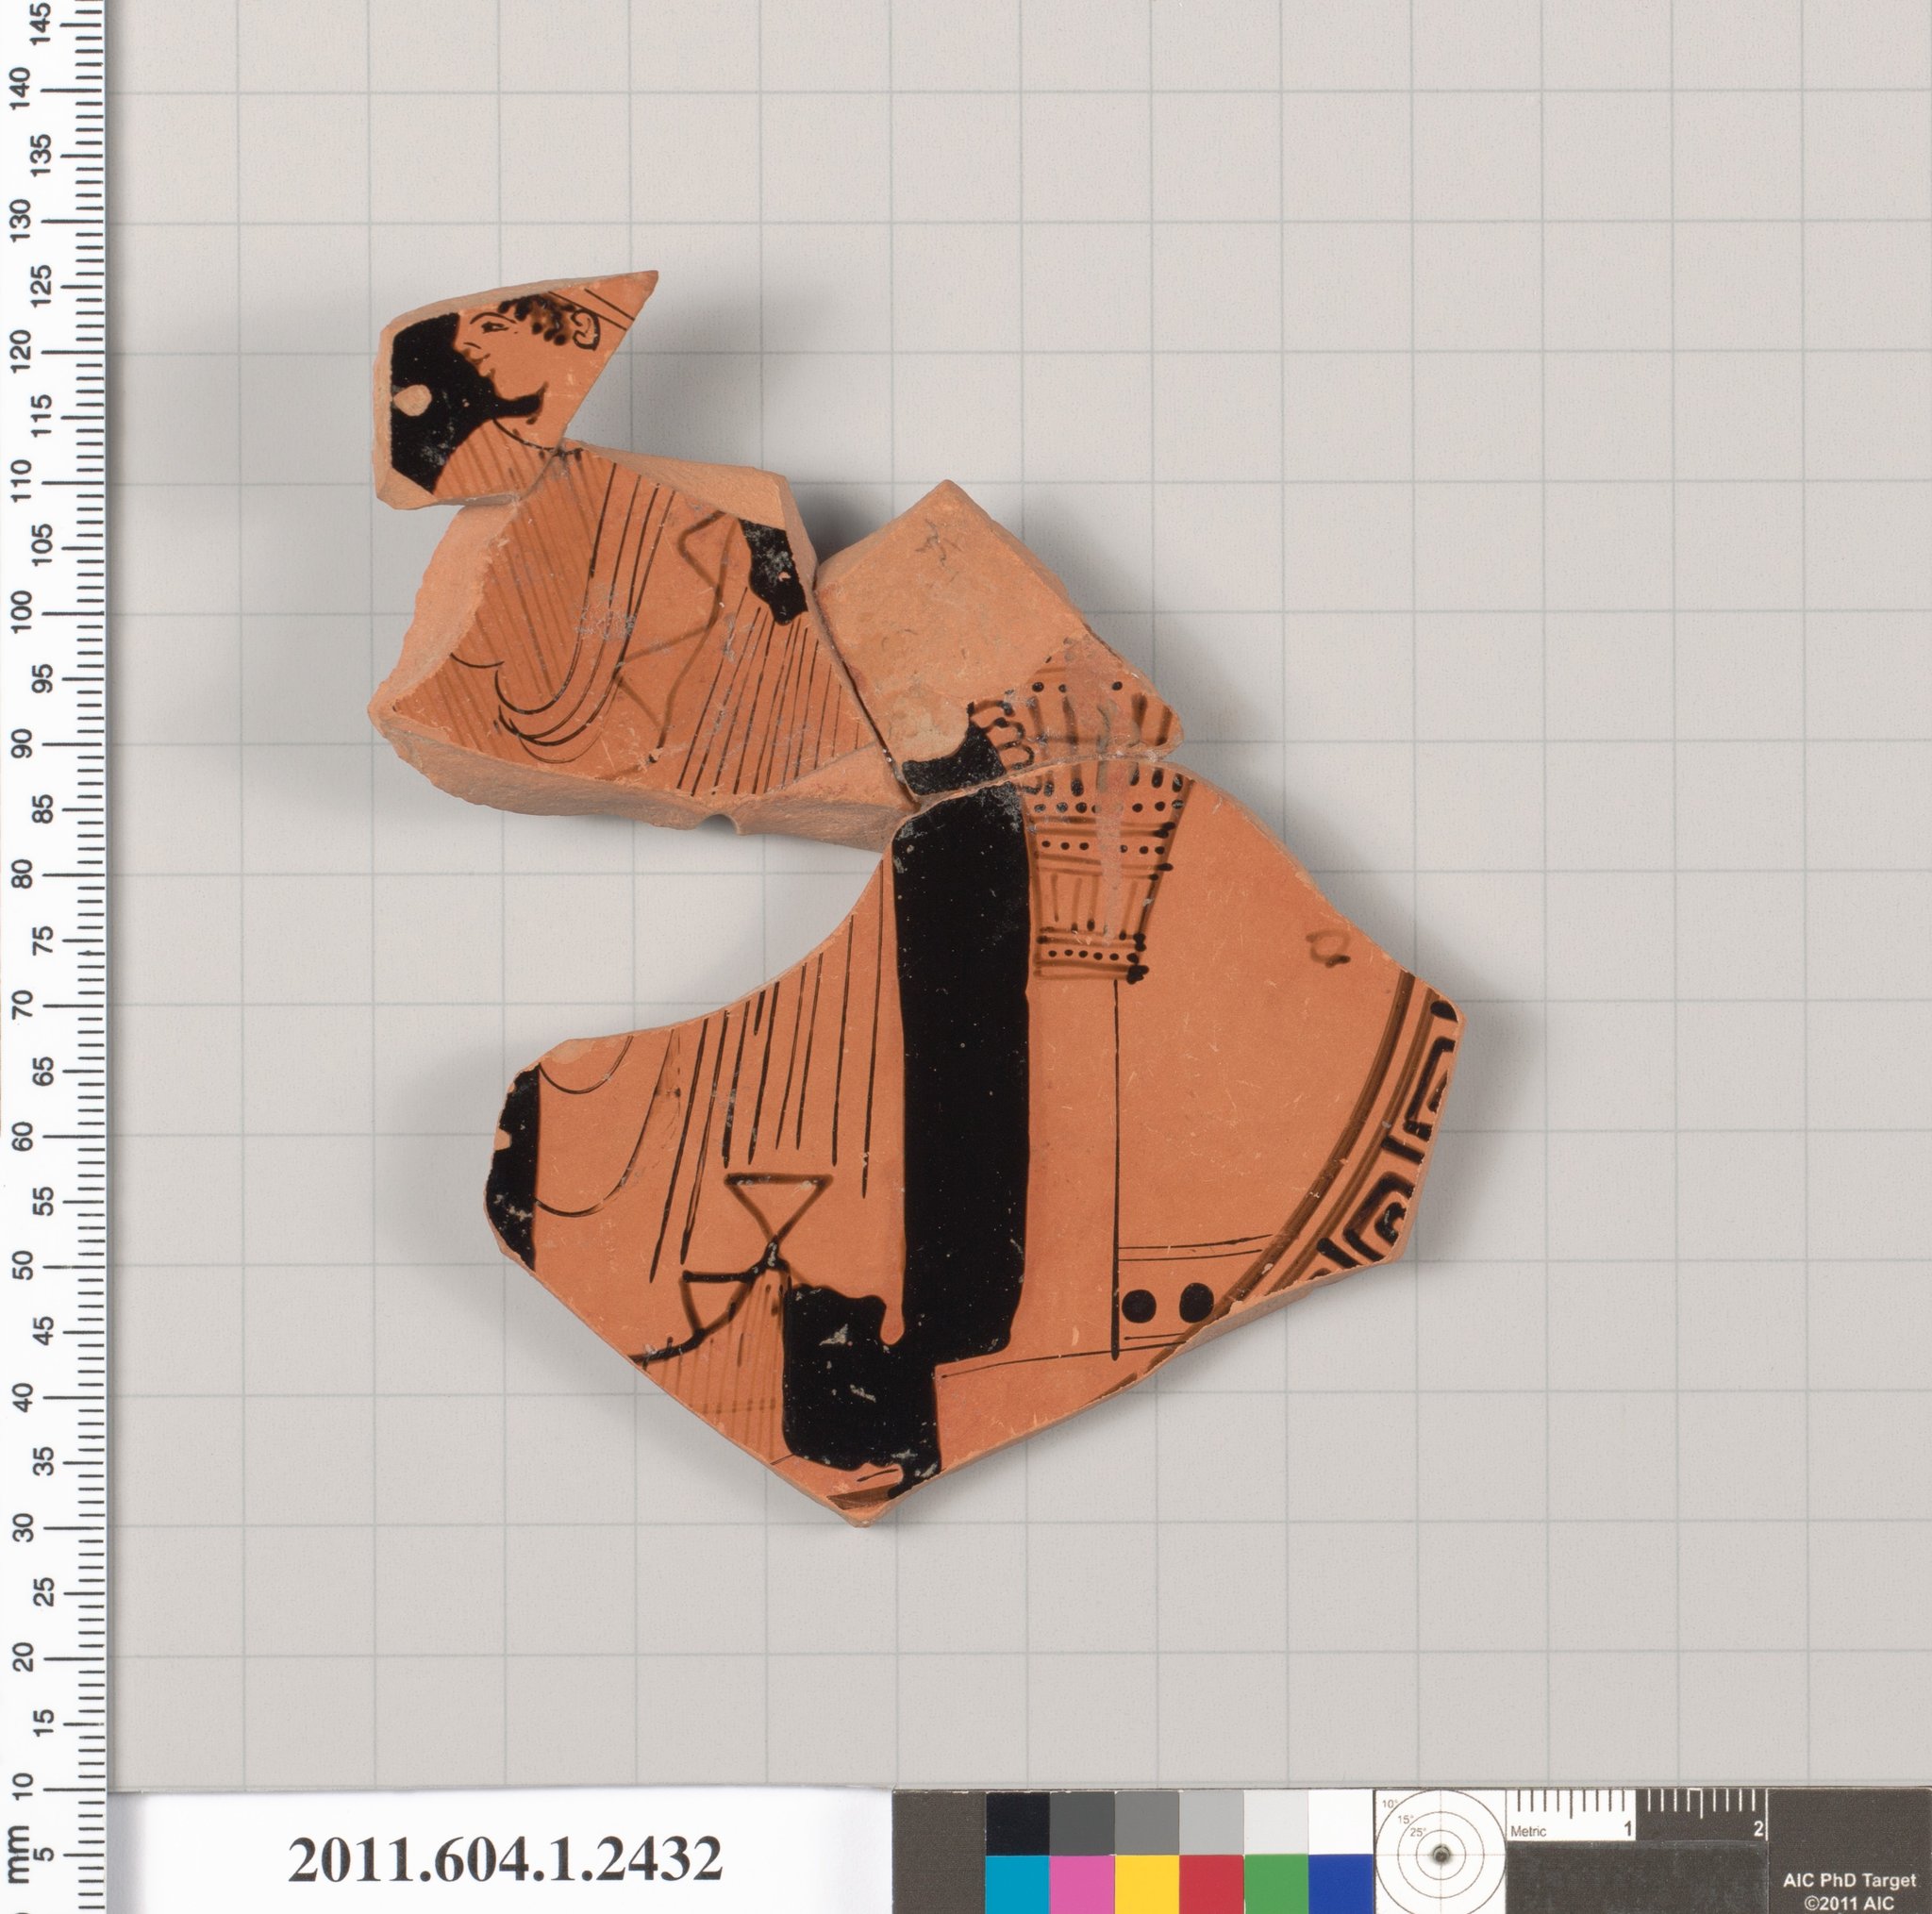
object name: kylix fragment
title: Terracotta fragment of a kylix (drinking cup)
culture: greek, attic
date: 475-451 BCE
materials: terracotta